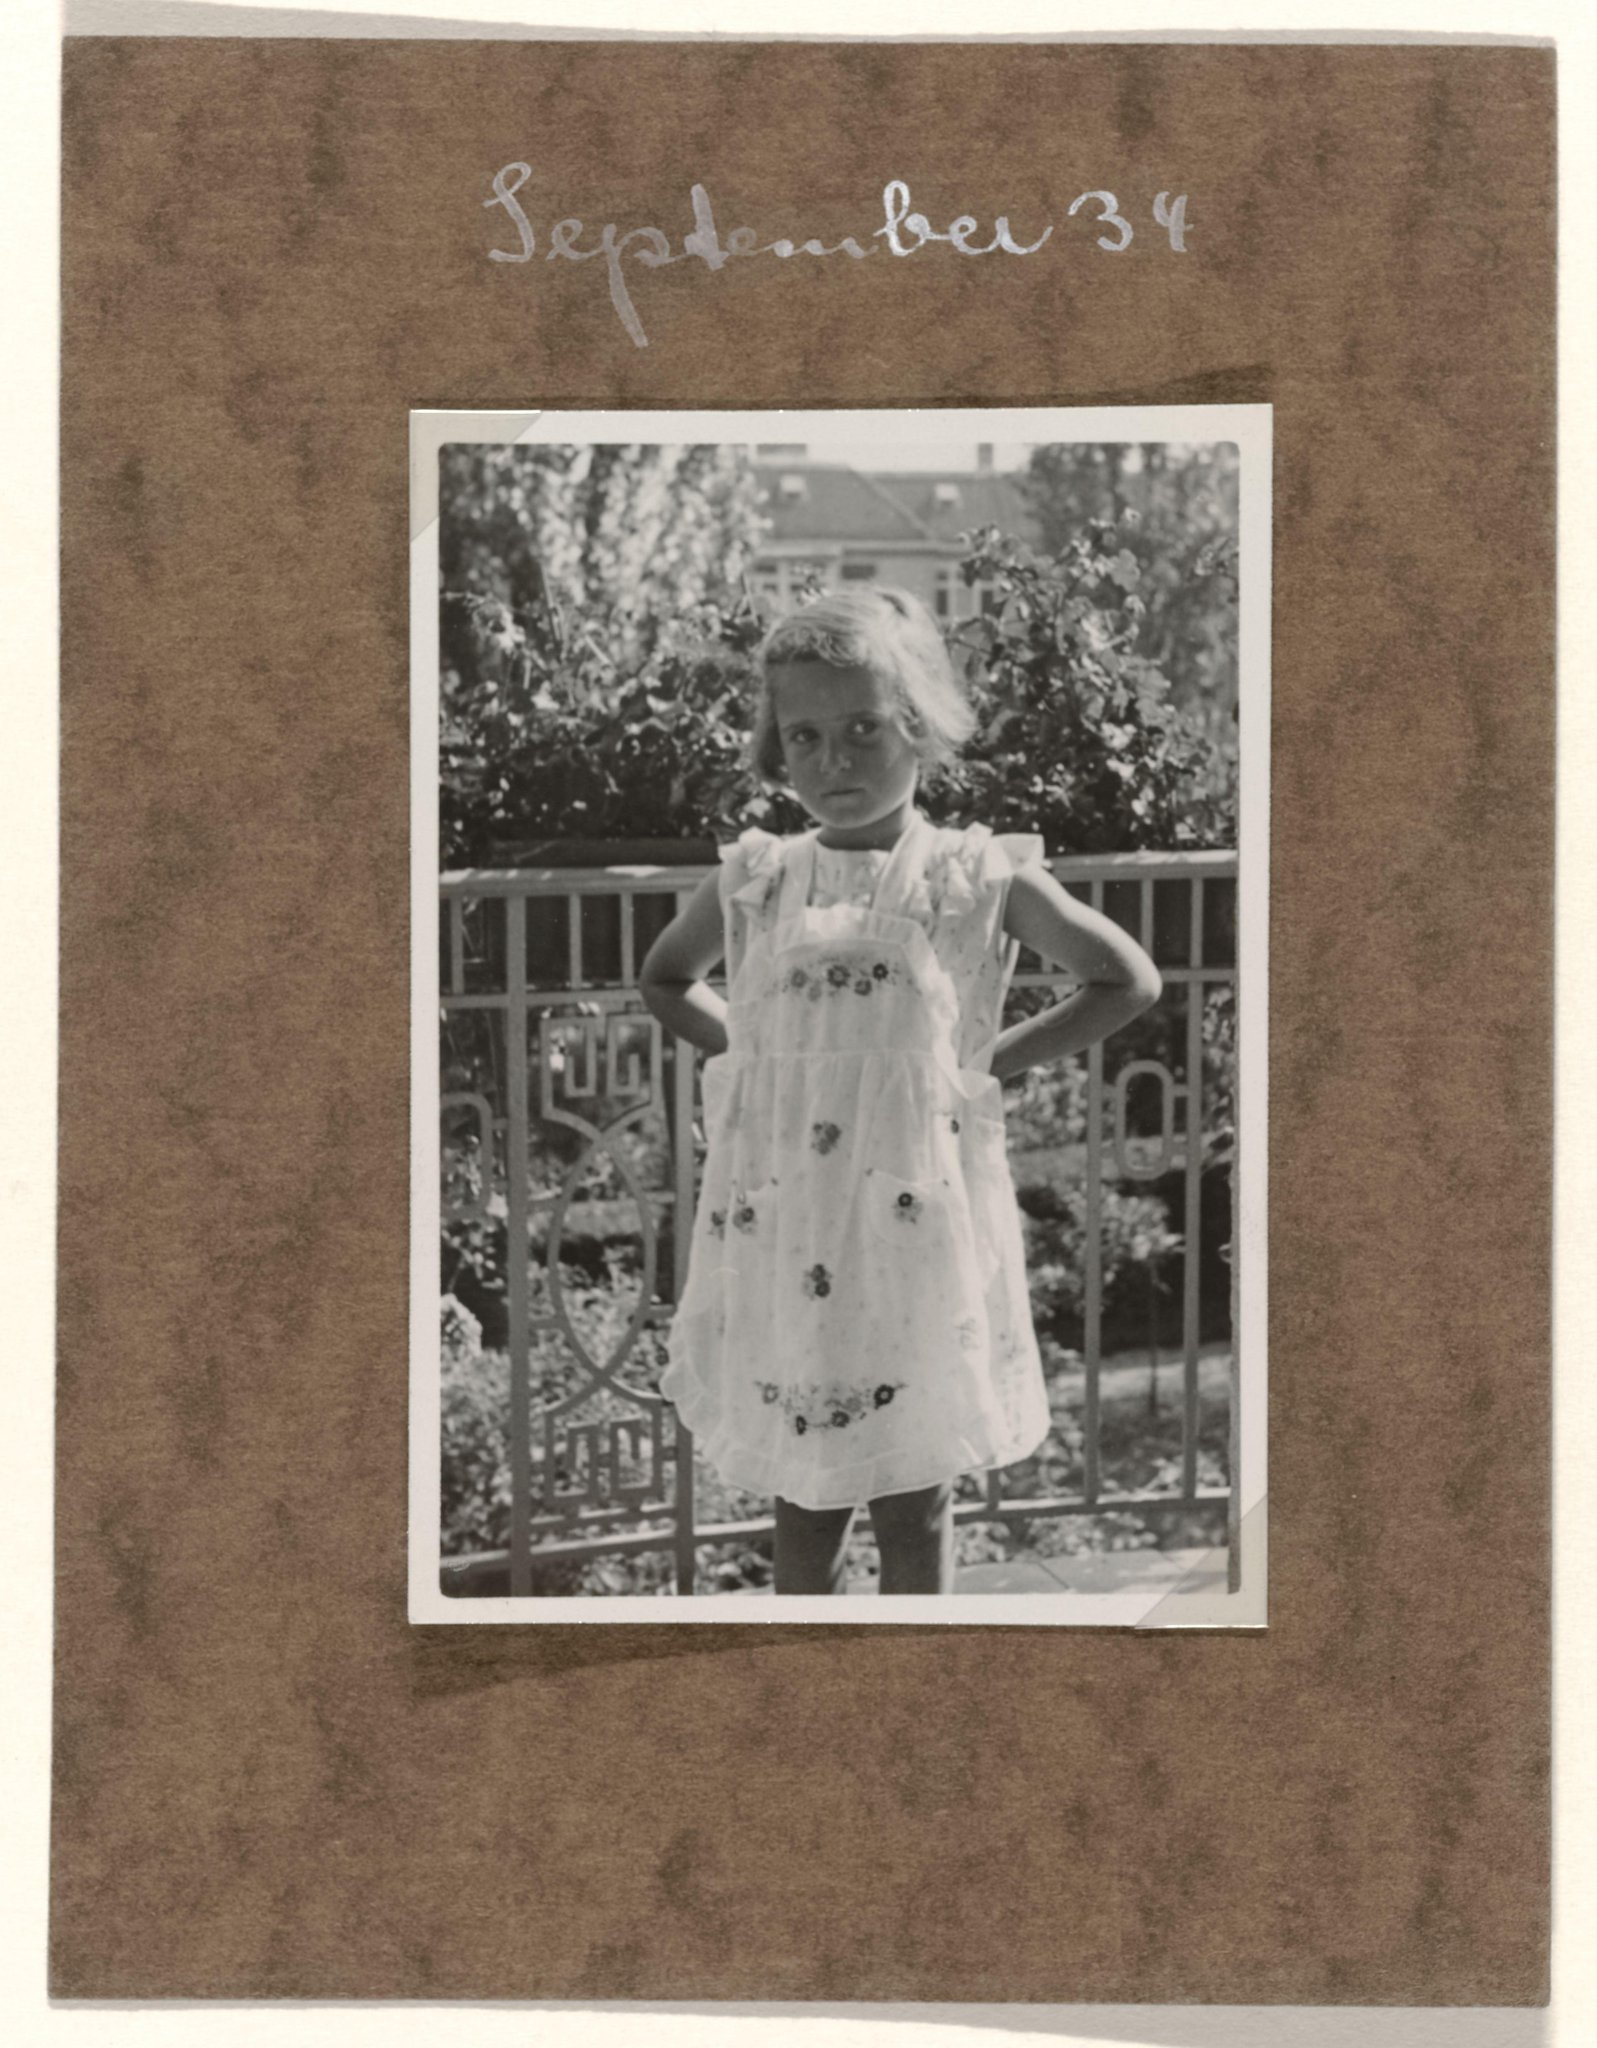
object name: photograph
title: Isabel Wachenheimer in jurk voor een hek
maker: Anonymous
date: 1909-1934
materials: photographic support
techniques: gelatin silver print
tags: leiden, isabel wachenheimer-elon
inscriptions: date: ‘September 34’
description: Isabel Wachenheimer in een jurk voor een hek.